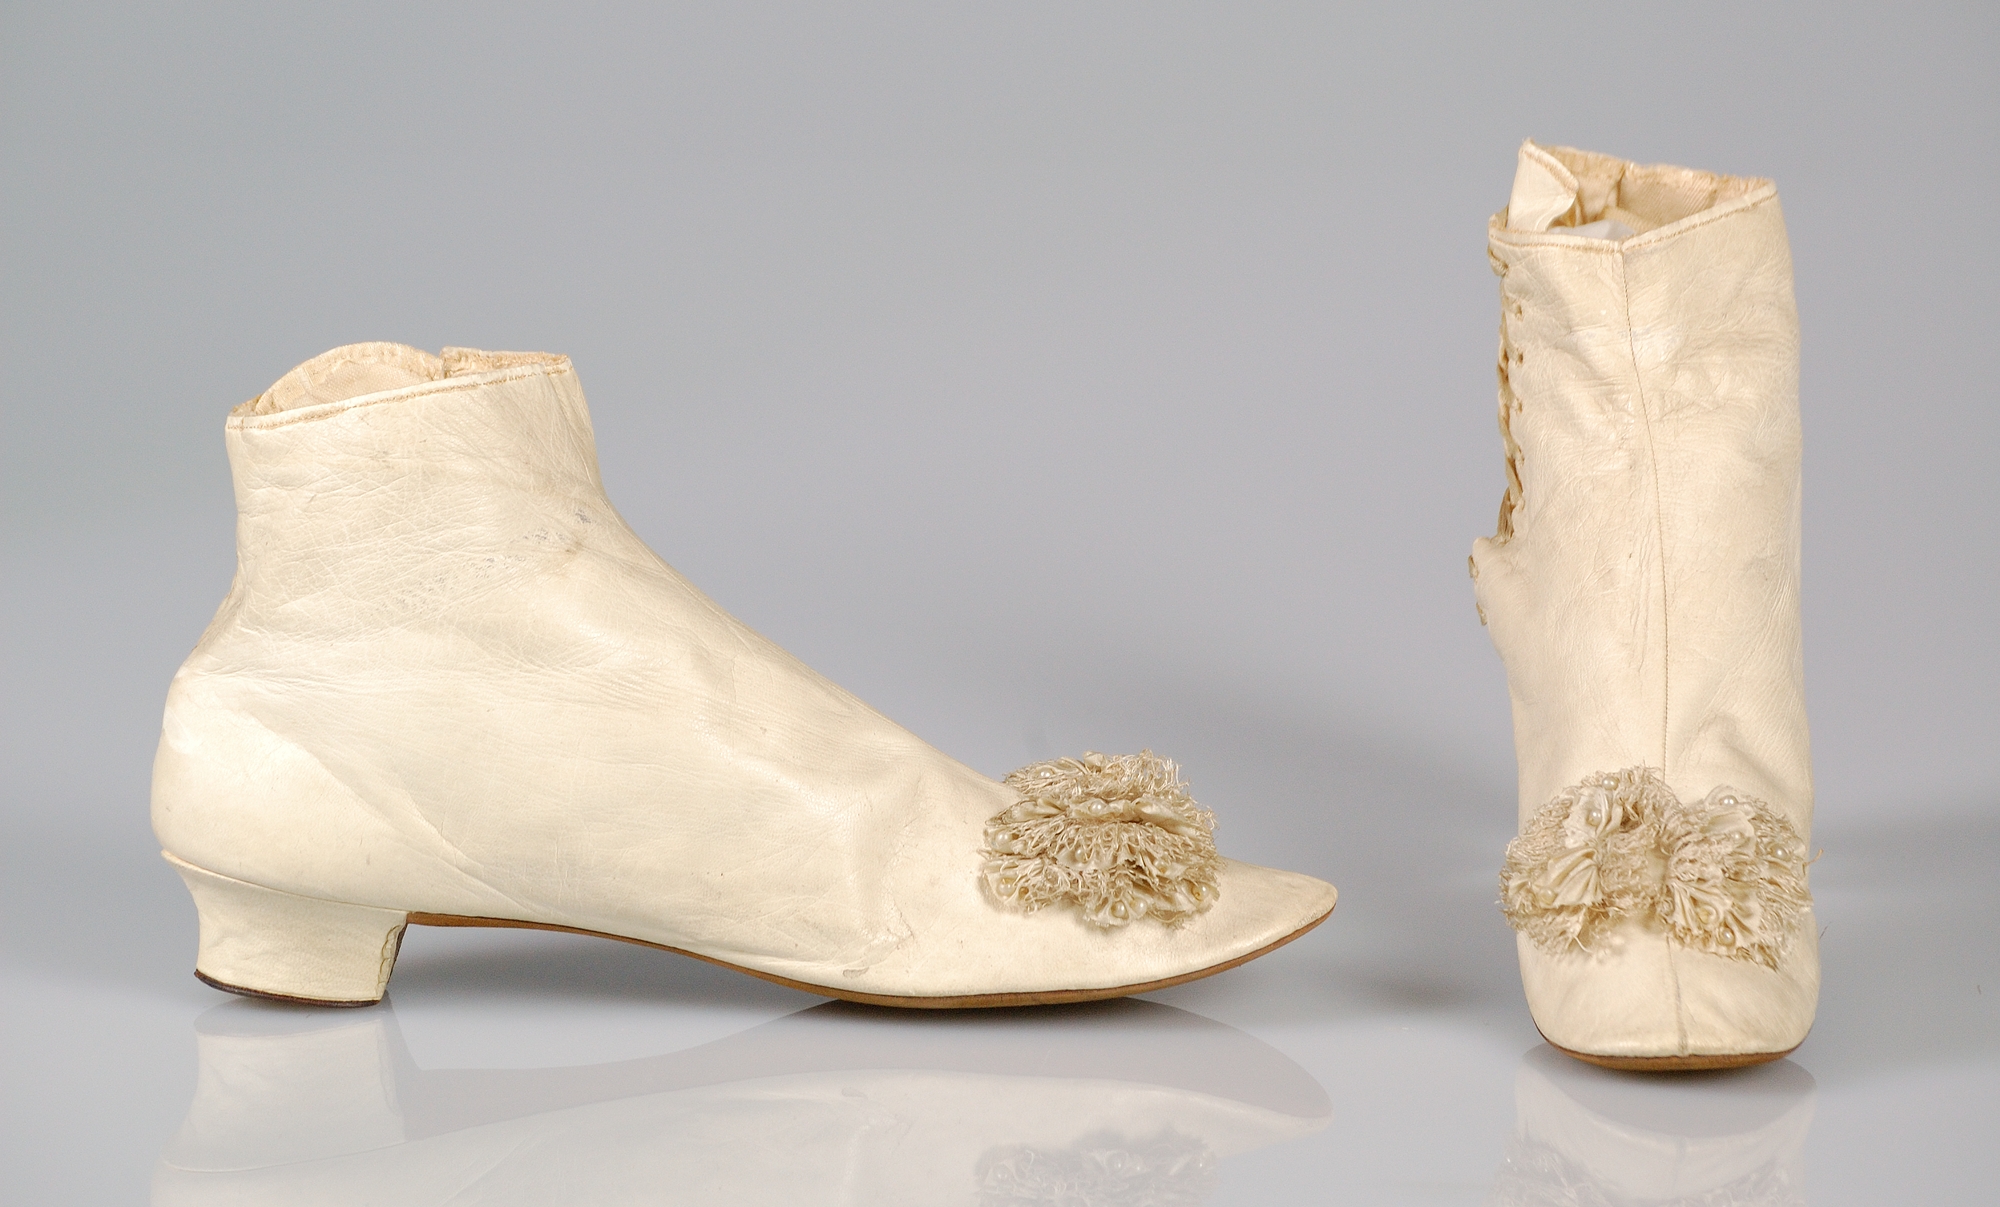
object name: evening boot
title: Evening boots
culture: french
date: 1855-1870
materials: leather, pearl, silk